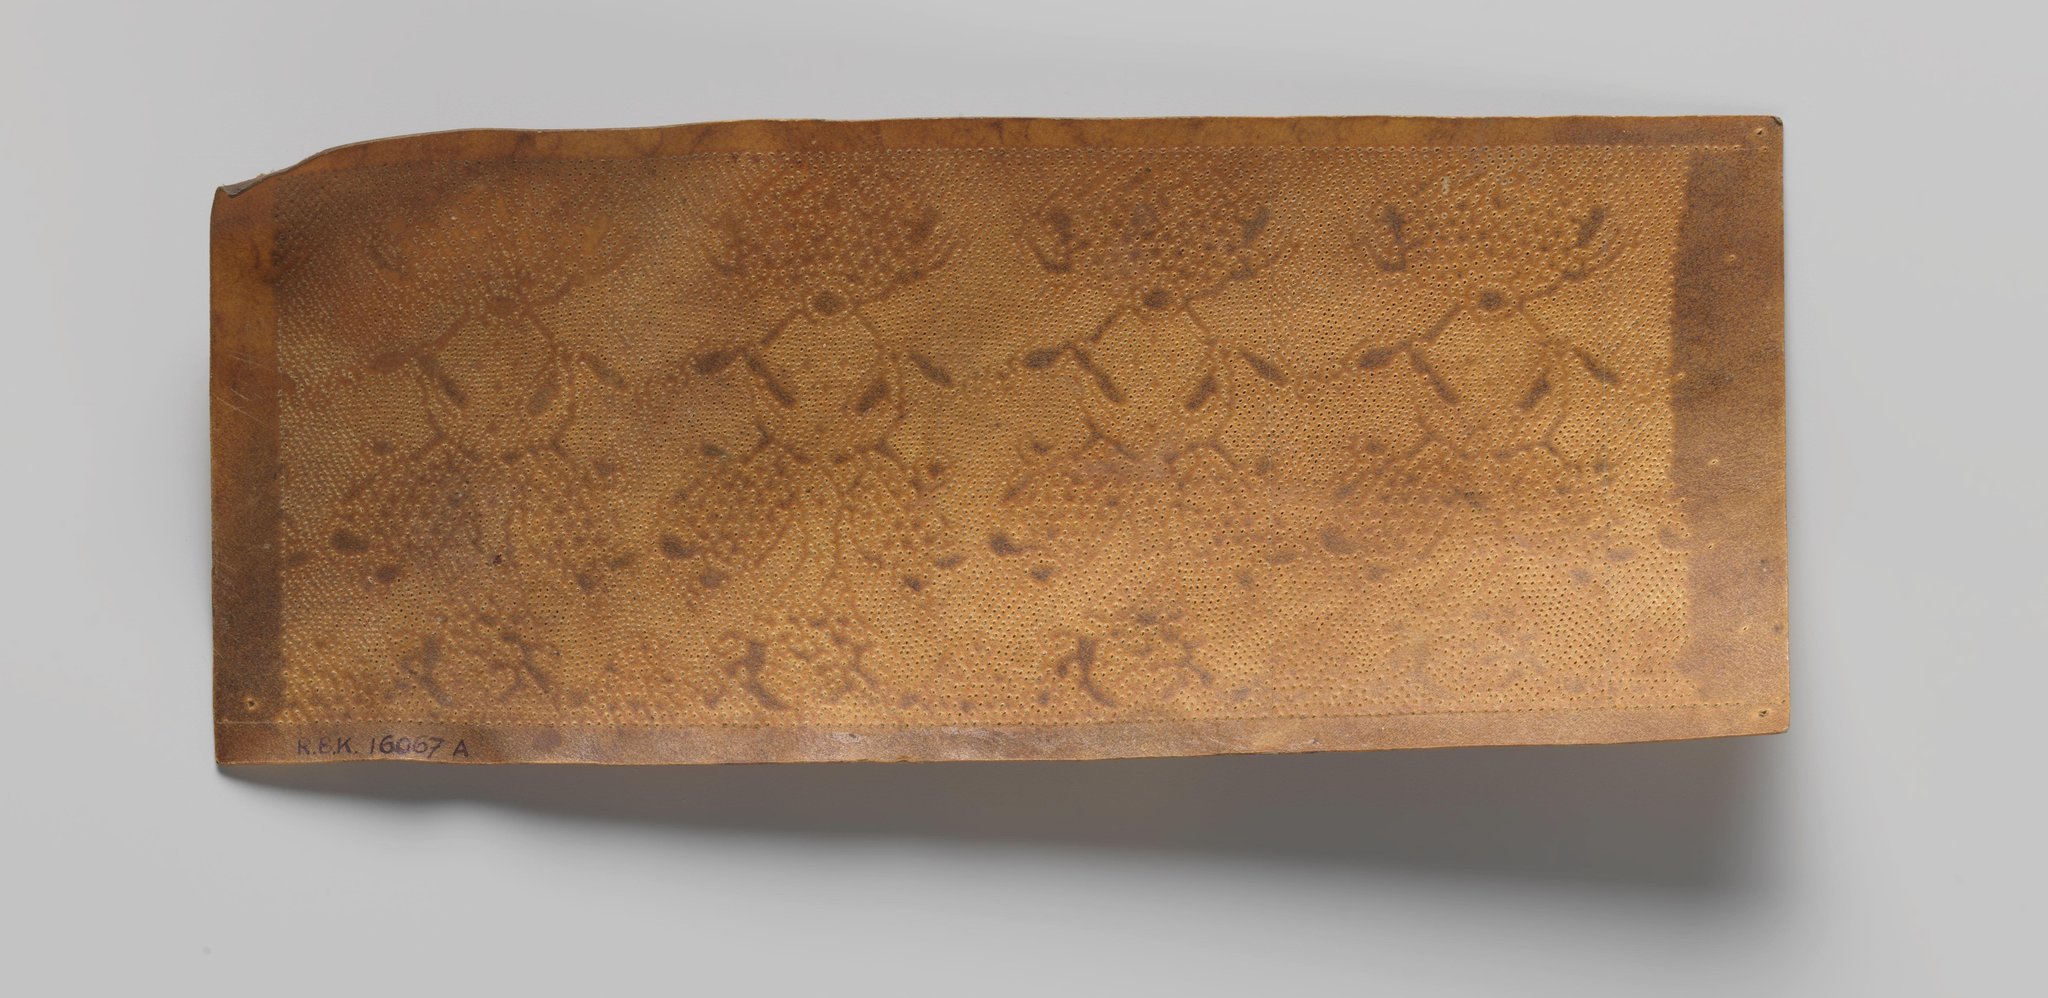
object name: prikking kloskant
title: Prikking voor een strook kloskant op bruin perkament met bloemen en gebogen ranken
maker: Anonymous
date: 1600-1799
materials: leather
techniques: pricking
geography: flanders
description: Patroon of werktekening voor een strook kloskant - Valenciennes-kant - geprikt in bruin gekleurd varkensleer. Het zich herhalende en doorlopende patroon bestaat uit gebogen ranken, bloemen en bladeren.